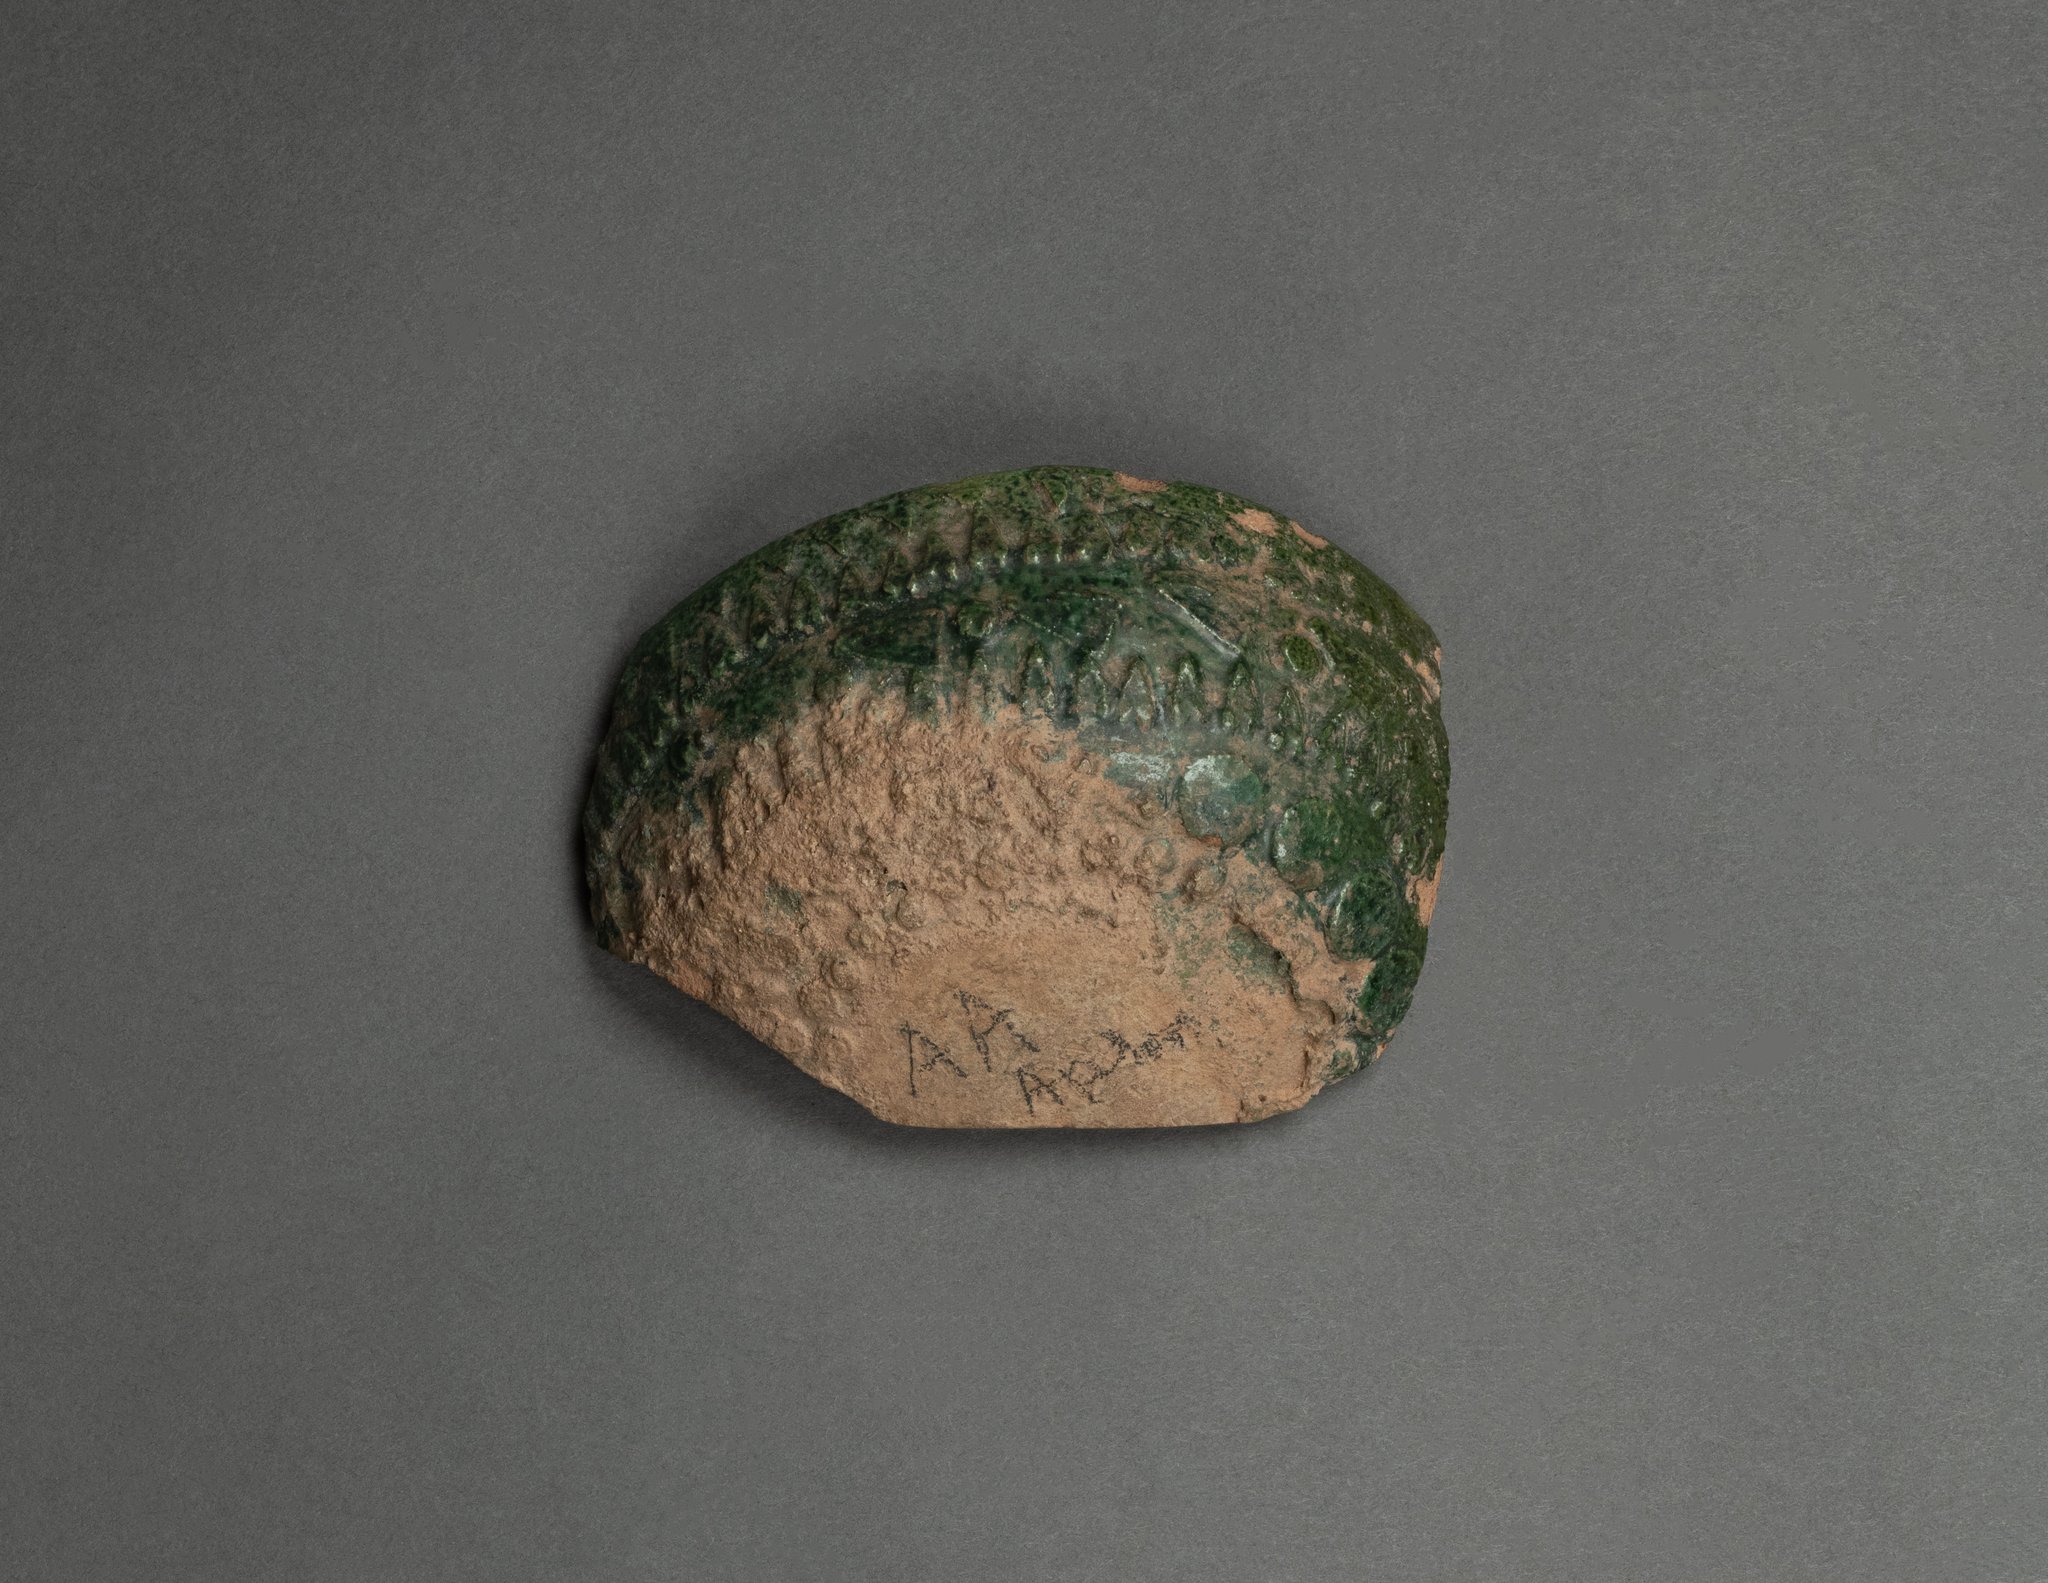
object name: fragment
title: Fragment of a Bowl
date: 801-900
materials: earthenware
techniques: glazing, molding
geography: iran